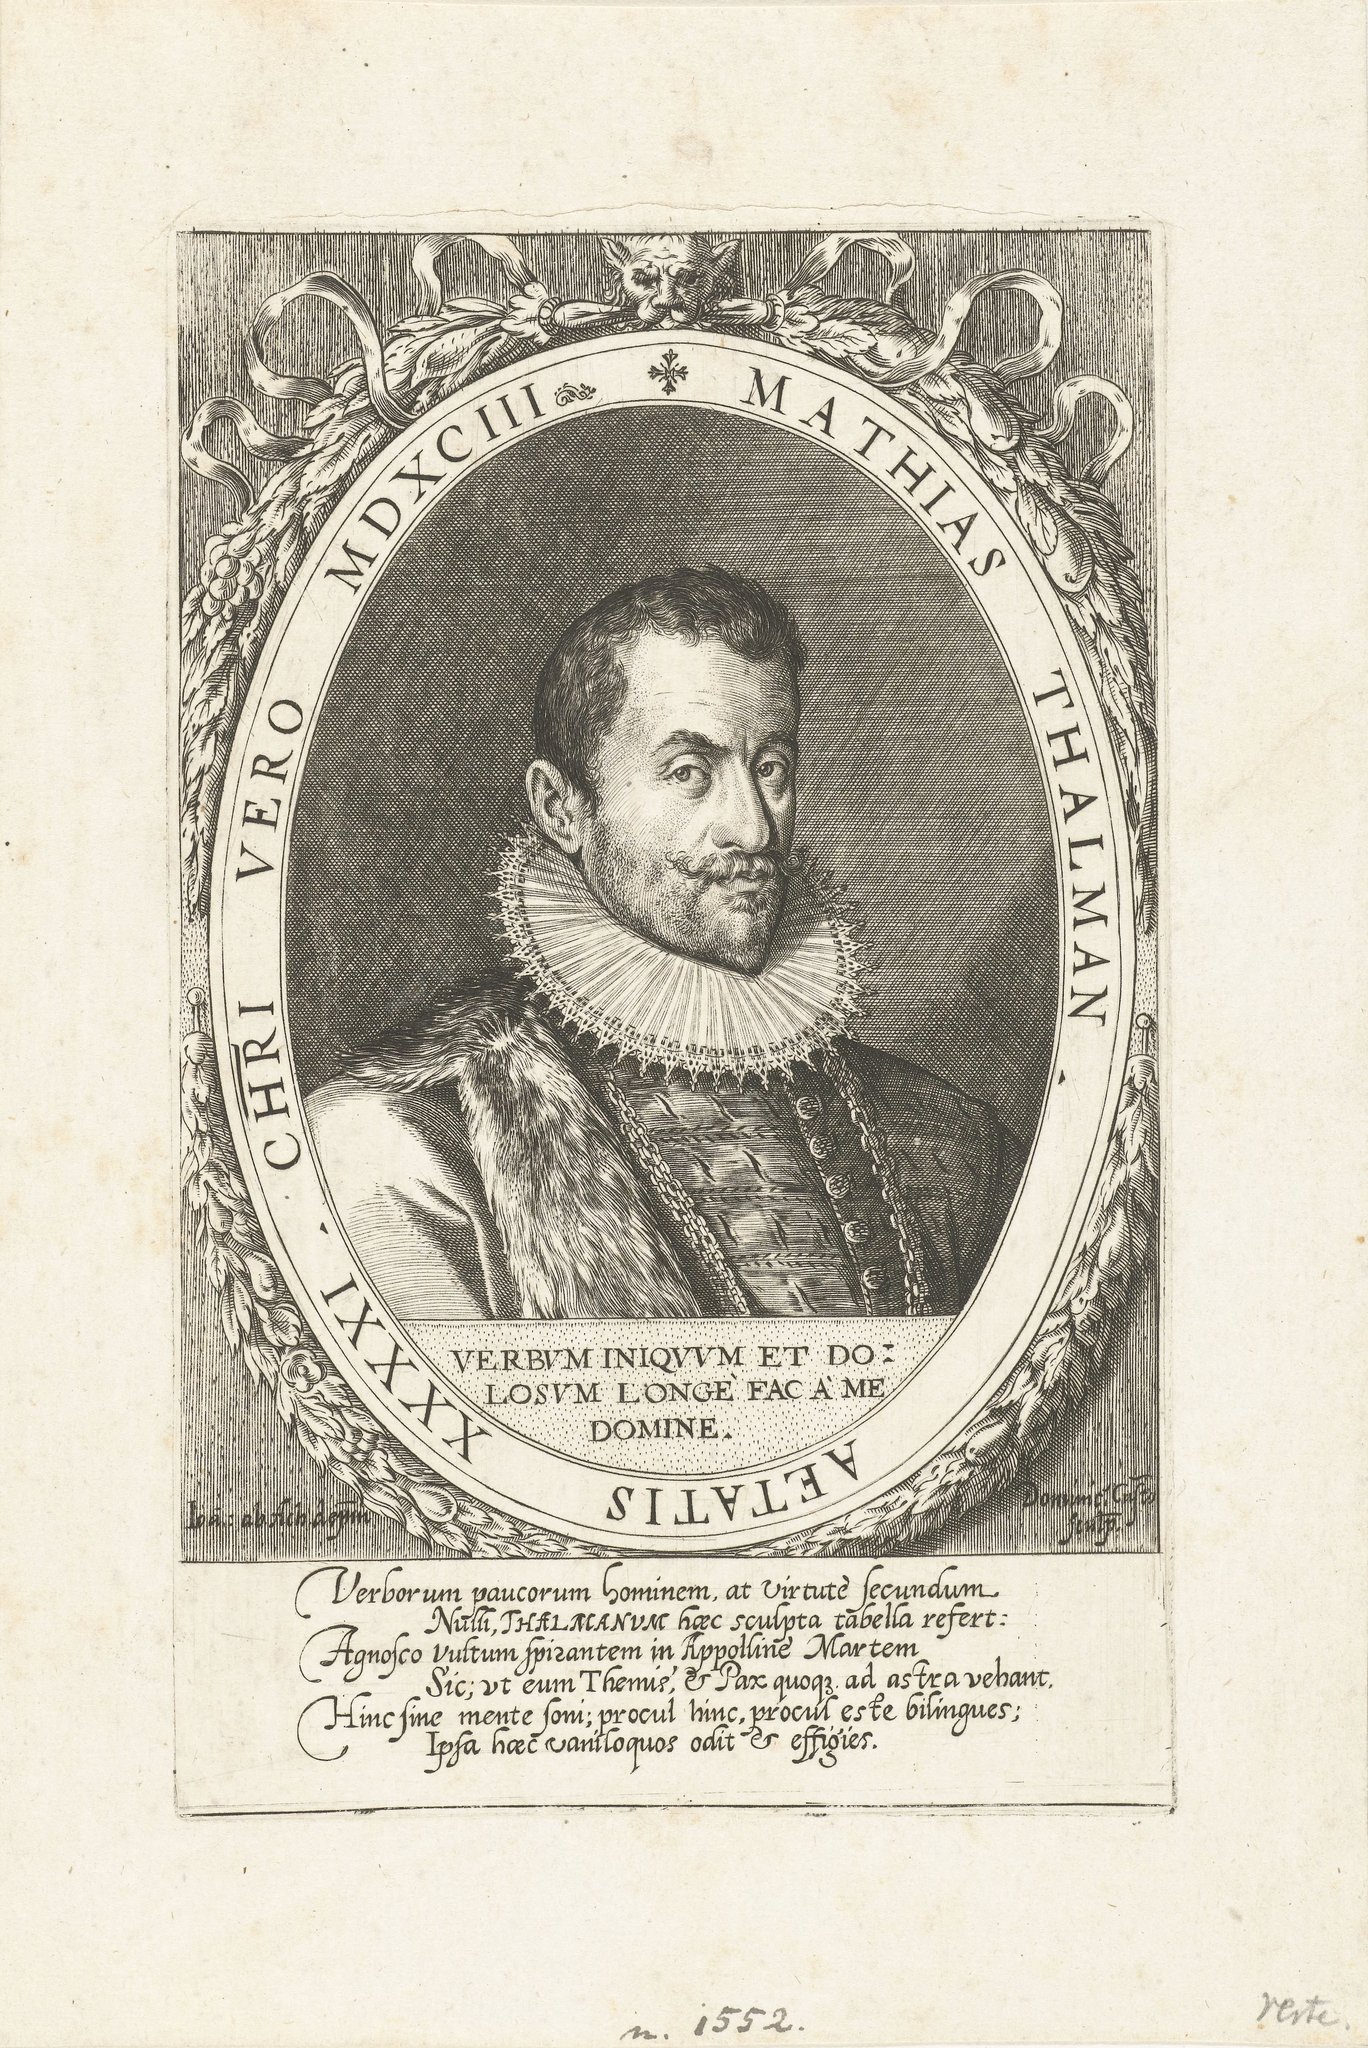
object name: print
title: Portret van ridder Matthias Thalmann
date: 1600-1615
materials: paper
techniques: engraving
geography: augsburg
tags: ridder, prefect, matthias thalmann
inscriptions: collector's mark: Lugt 2228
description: Niet afkomstig uit: Illustratie uit: D. Custos en M. Henning. Atrium heroicum Caesarum, regum aliorq. summatum ac procerum qui intra proximum seculum vixere, aut hodie supersunt, imaginib. Deel 1-4. Augsburg: D. Custos, 1600-1604. Hier ander portret van Thalmann.